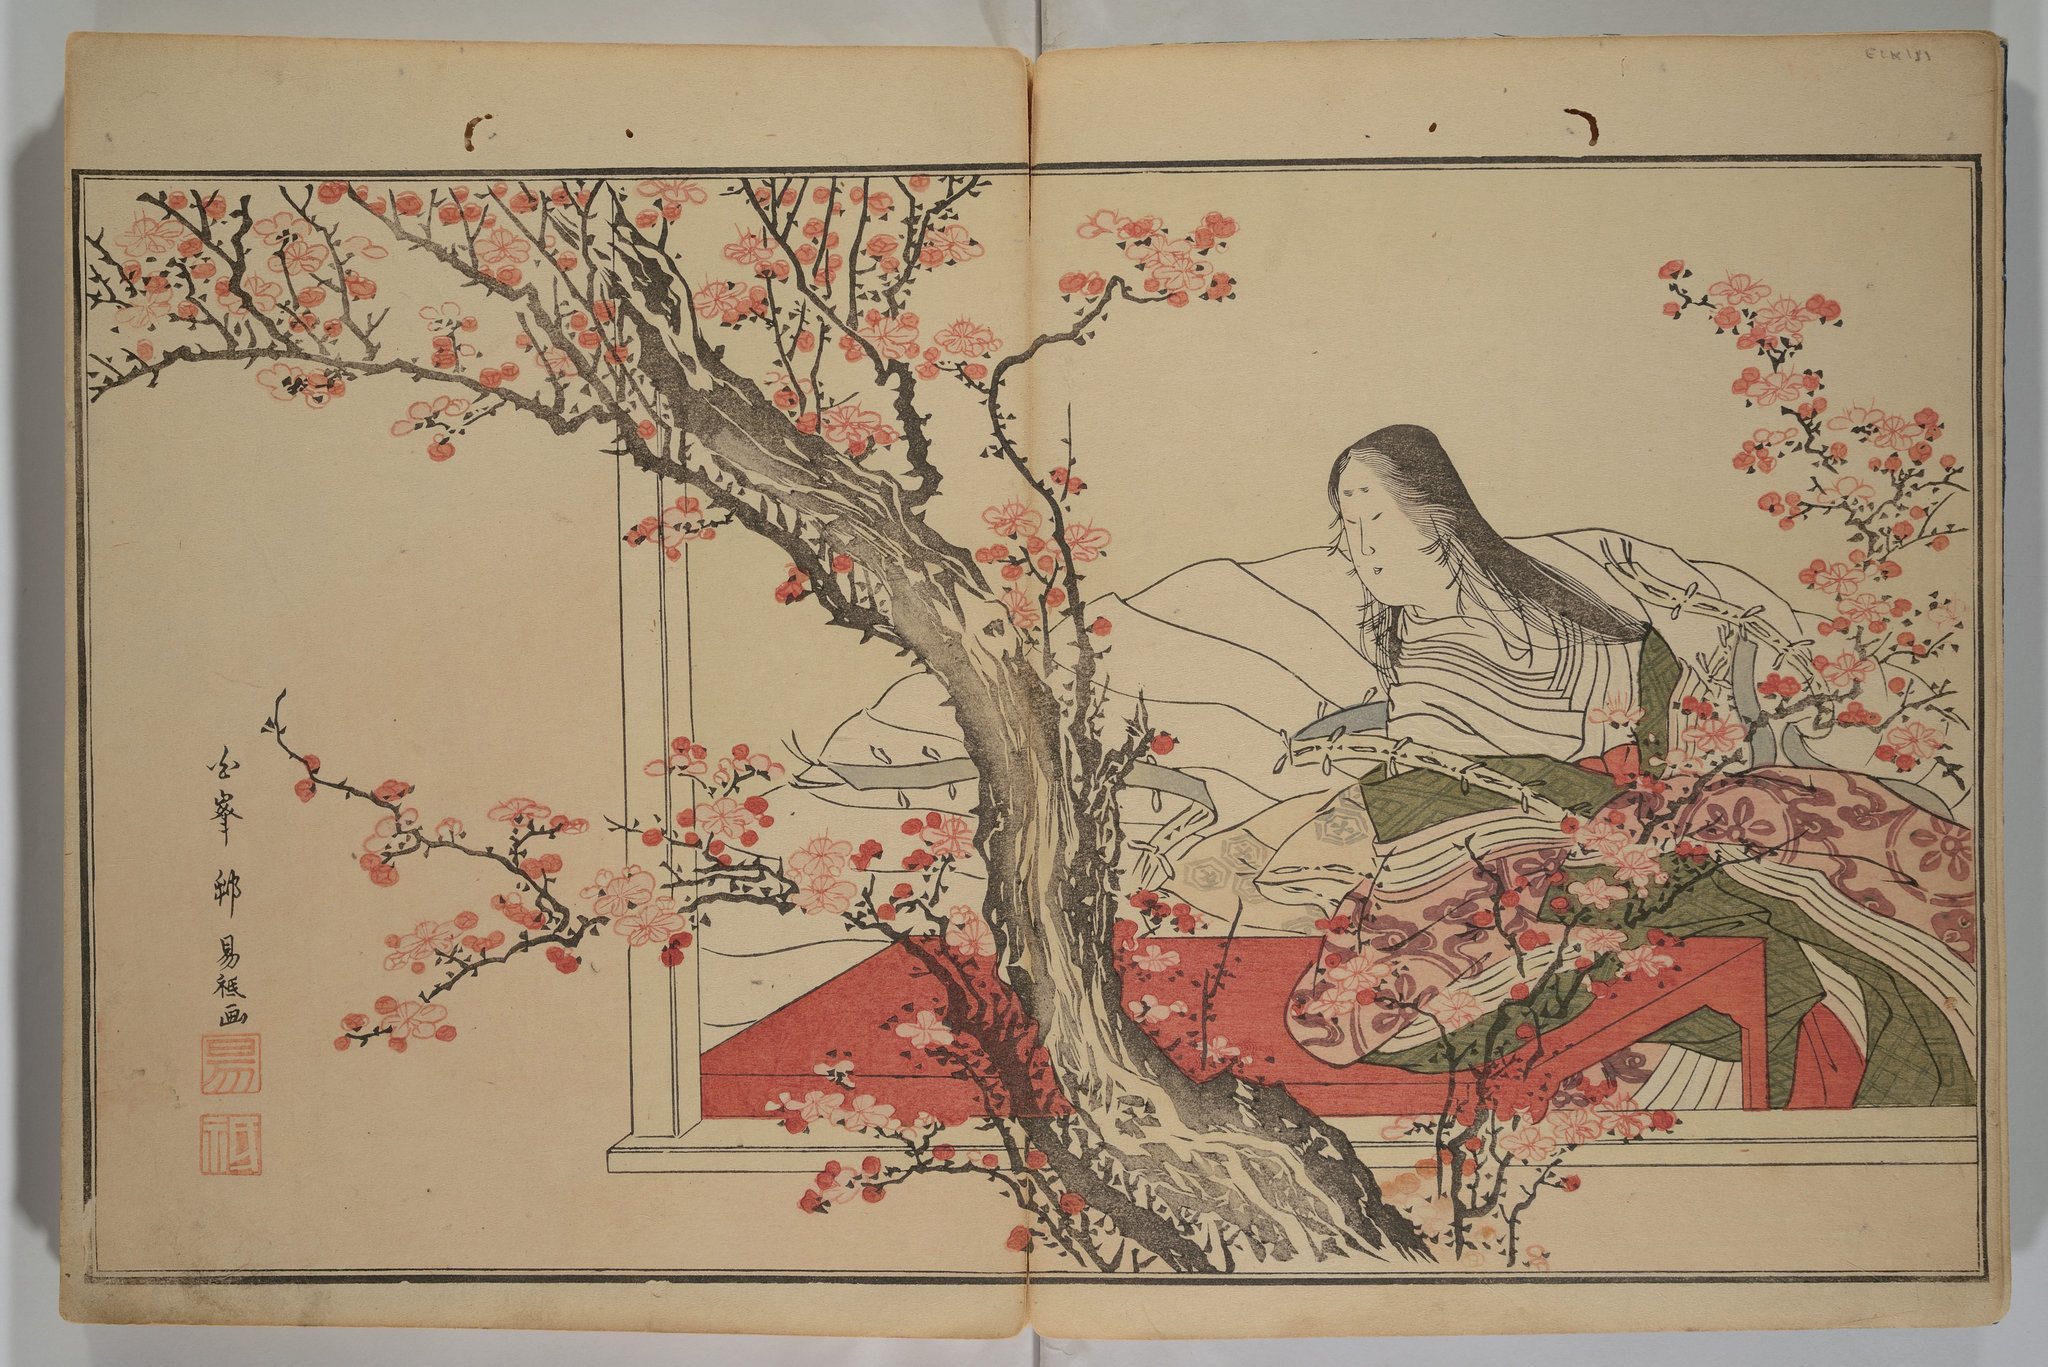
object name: illustrated book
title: Men’s Stomping Dances (Otoko tōka) 男踏歌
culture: japanese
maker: chōbunsai eishi 鳥文斎栄之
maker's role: artist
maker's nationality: japanese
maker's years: 1756-1829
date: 1798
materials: ink, paper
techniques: woodblock print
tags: men,dancing,flowers,trees